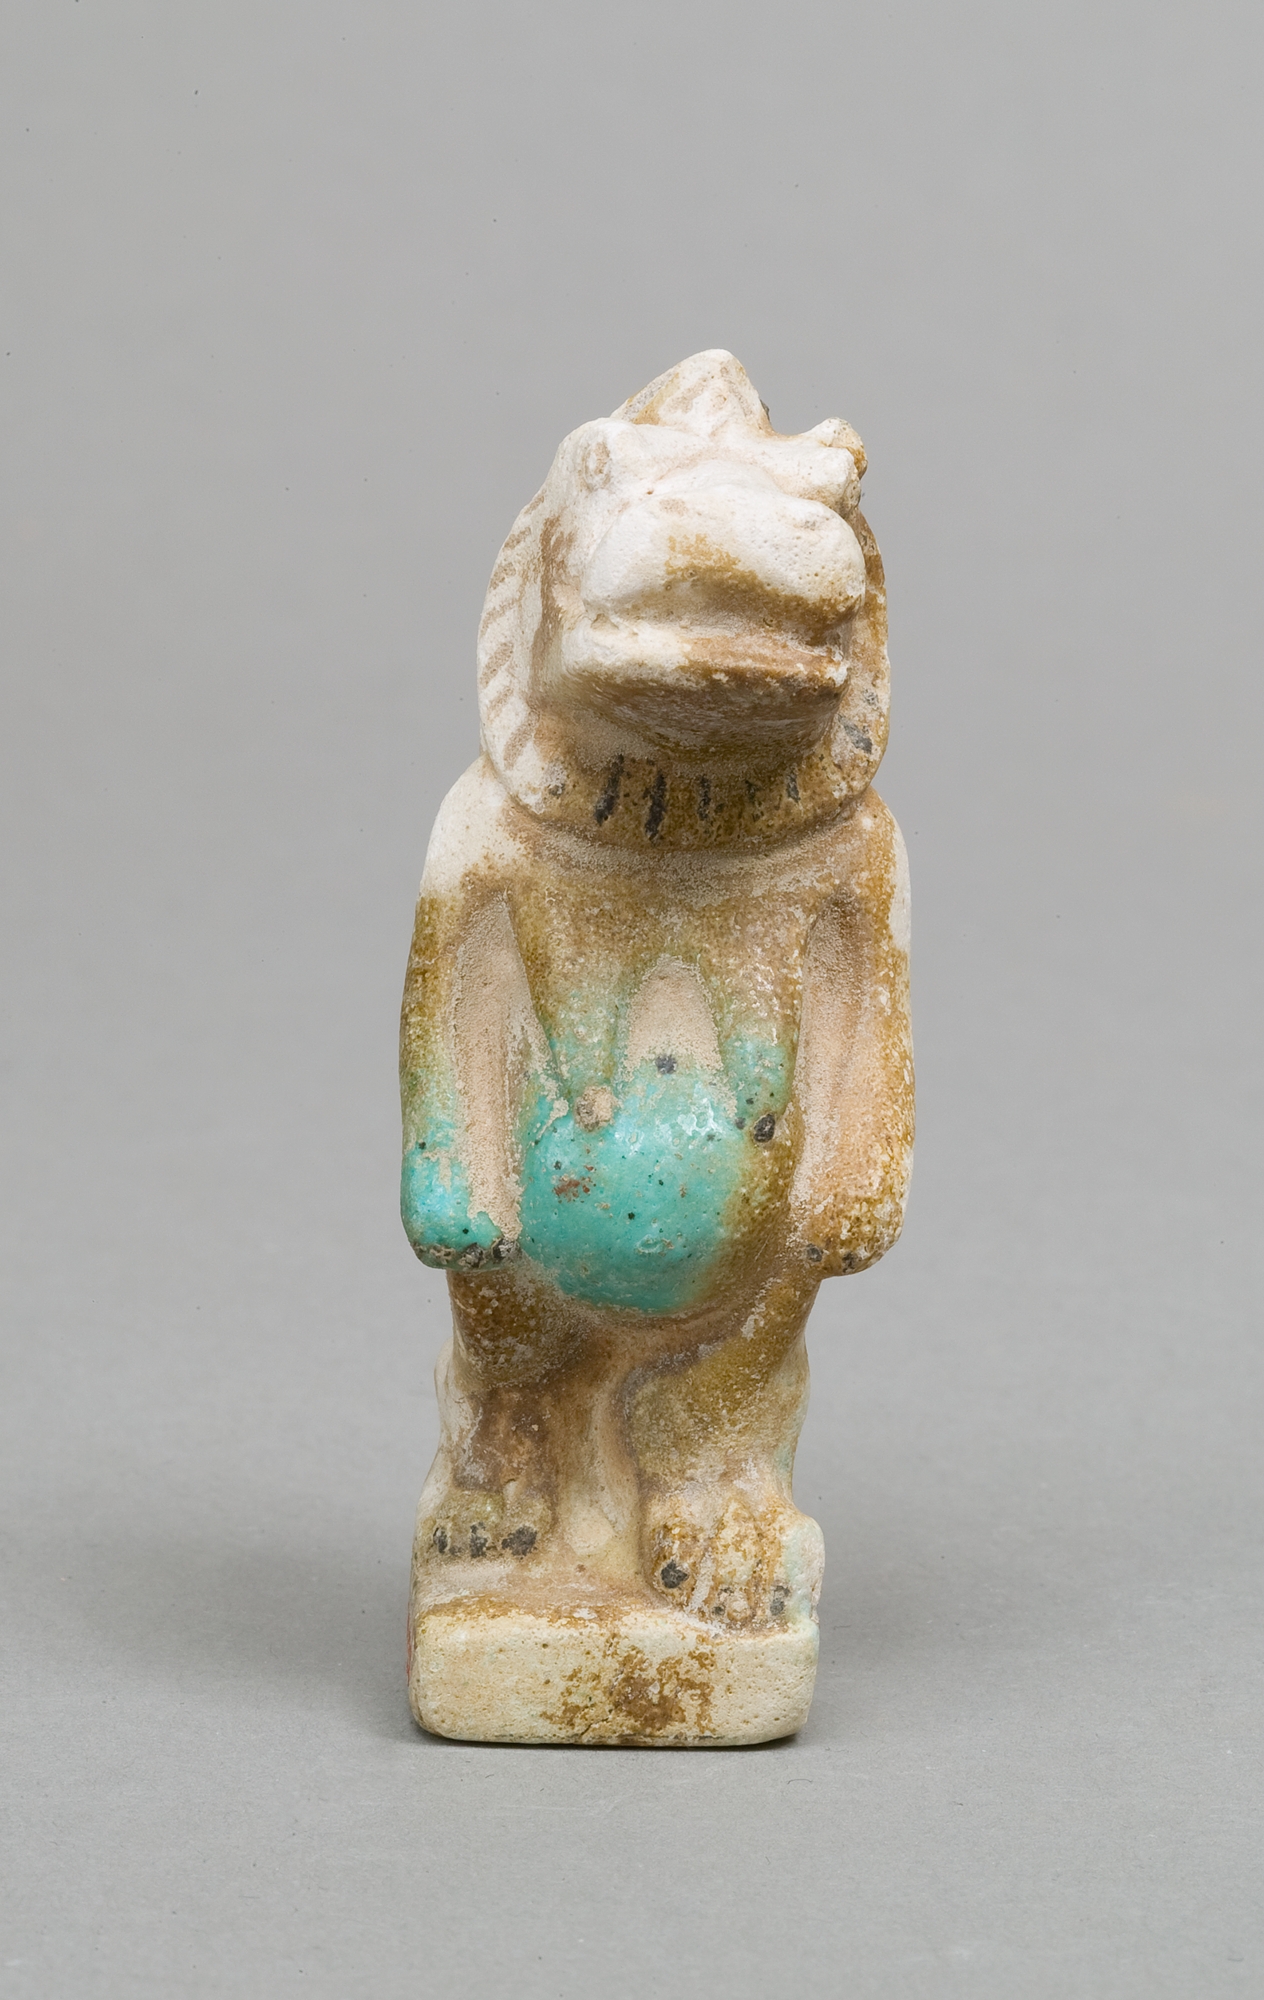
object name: statuette, taweret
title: Taweret statuette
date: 1950-1900 BCE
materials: faience, paint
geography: egypt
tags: taweret